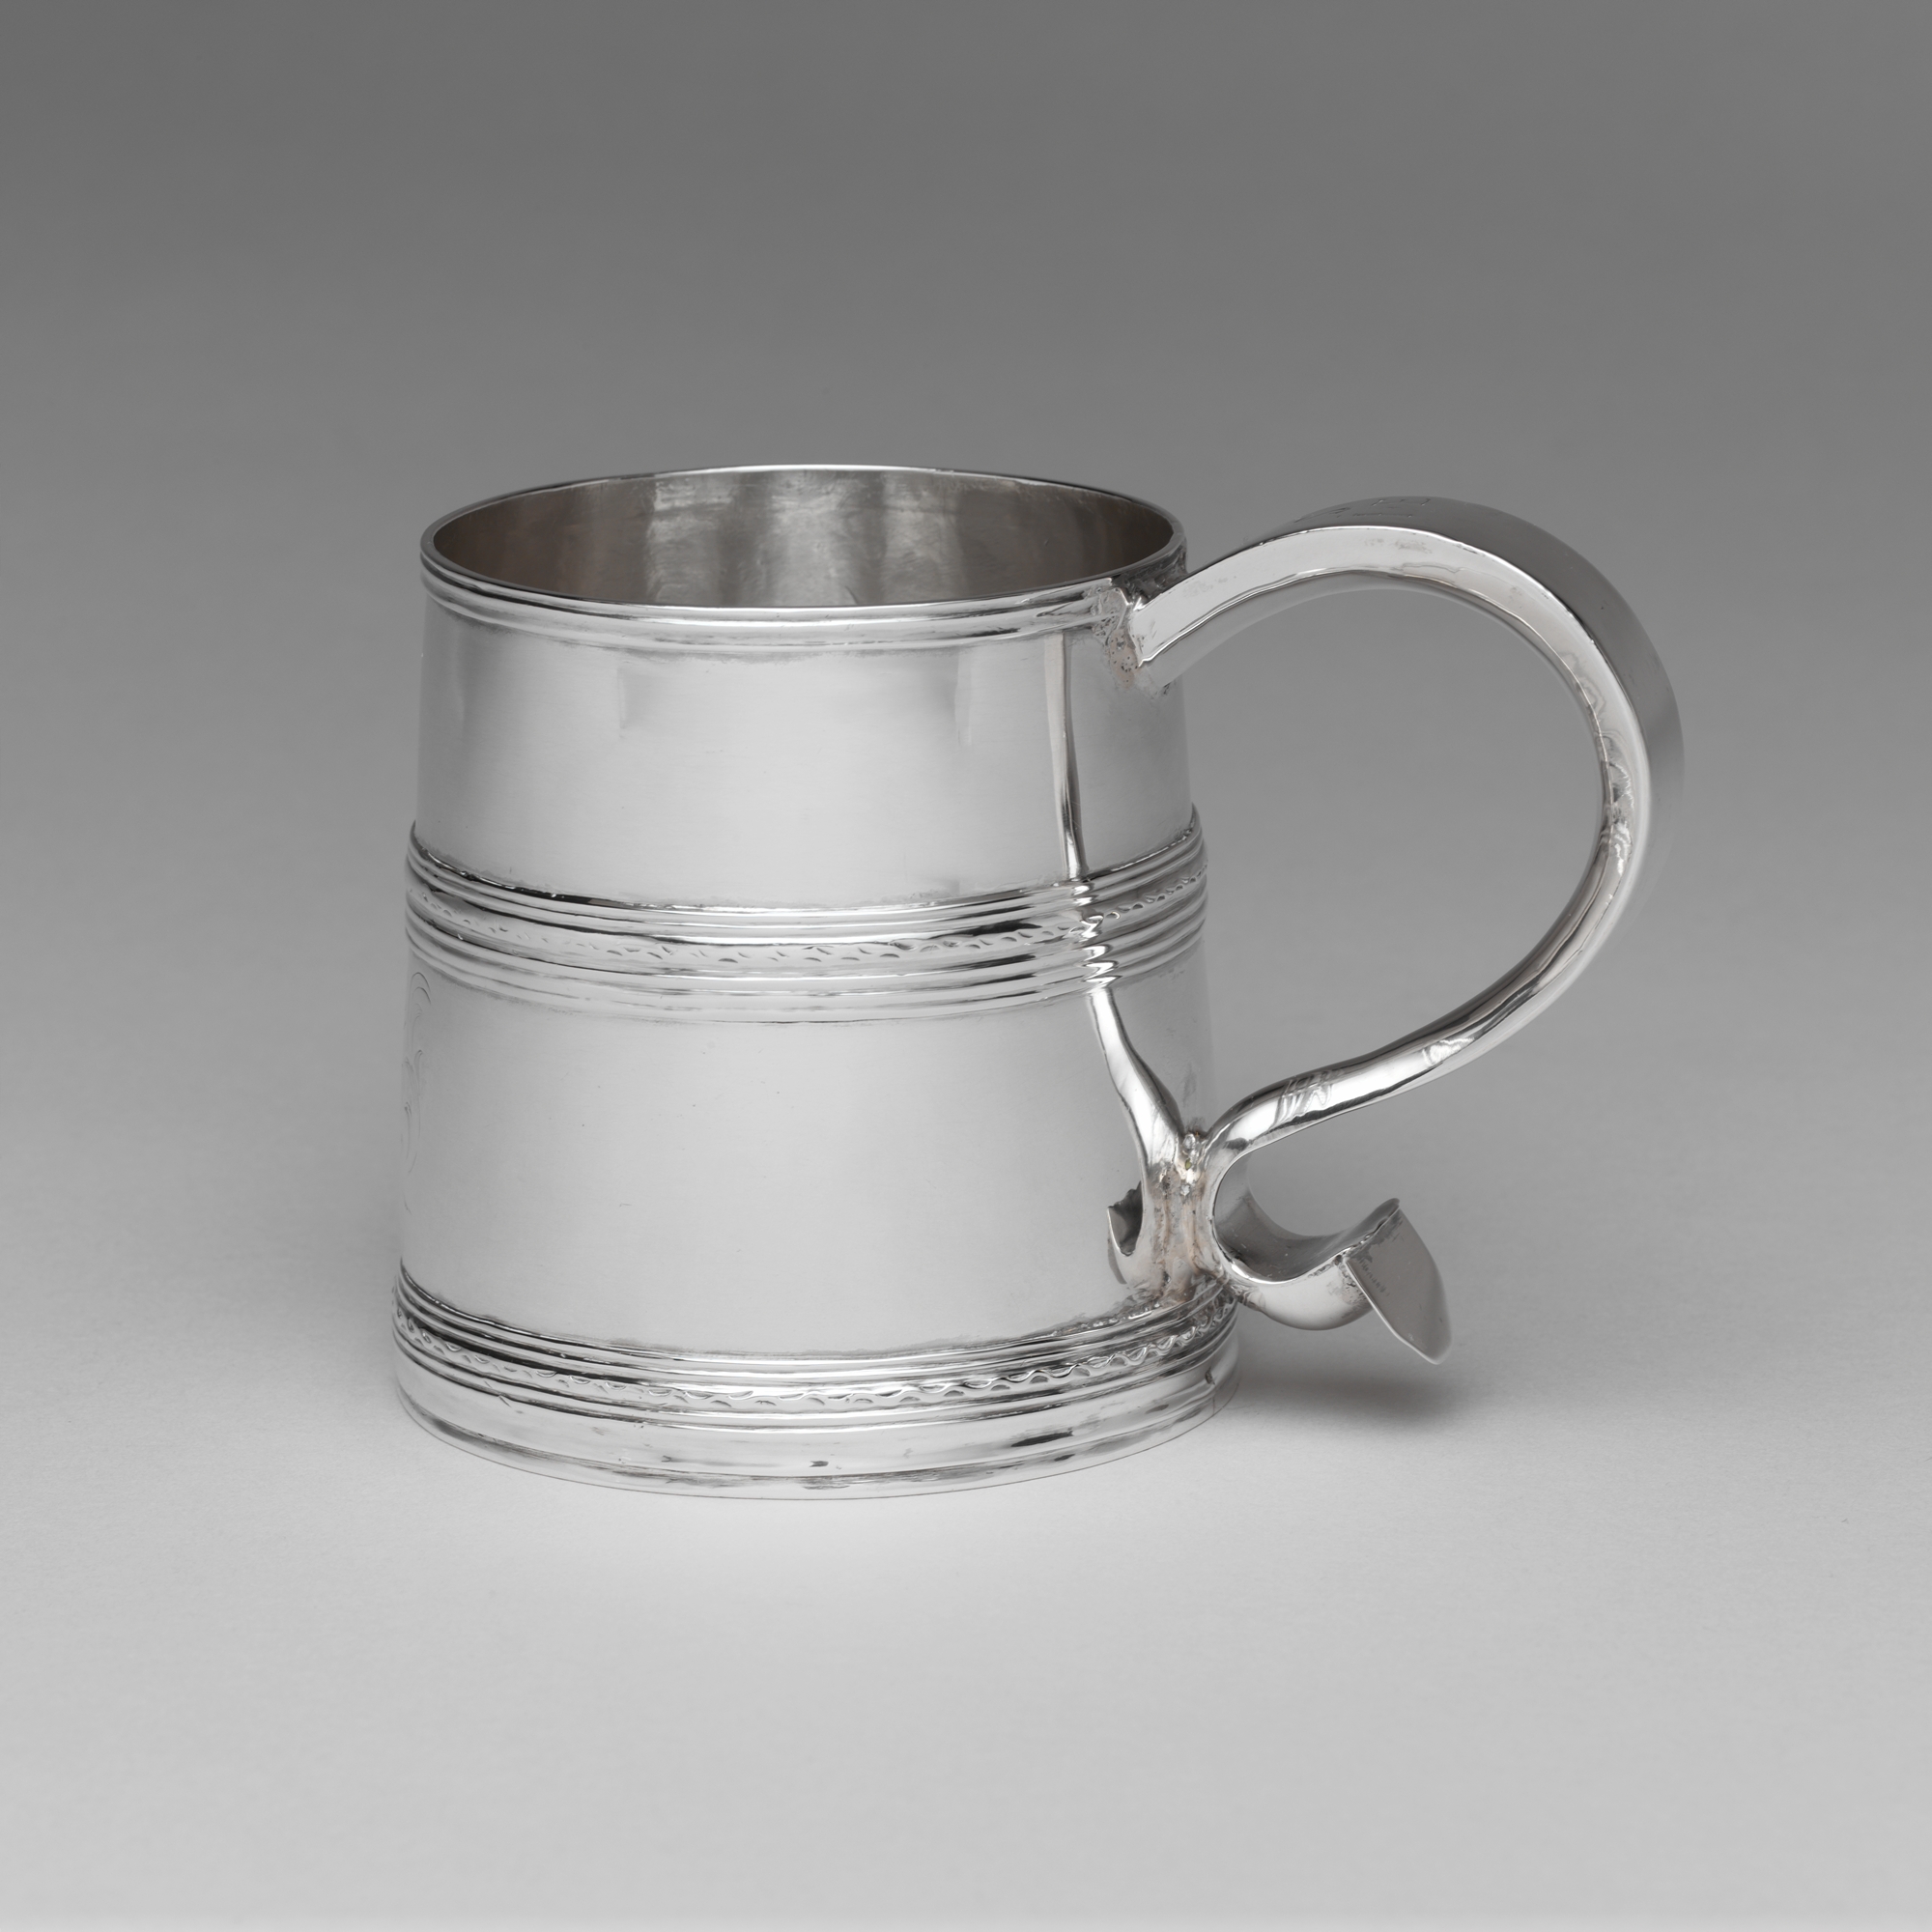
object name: mug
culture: american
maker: koenraet ten eyck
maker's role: maker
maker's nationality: american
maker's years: 1678-1753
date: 1700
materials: silver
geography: united states